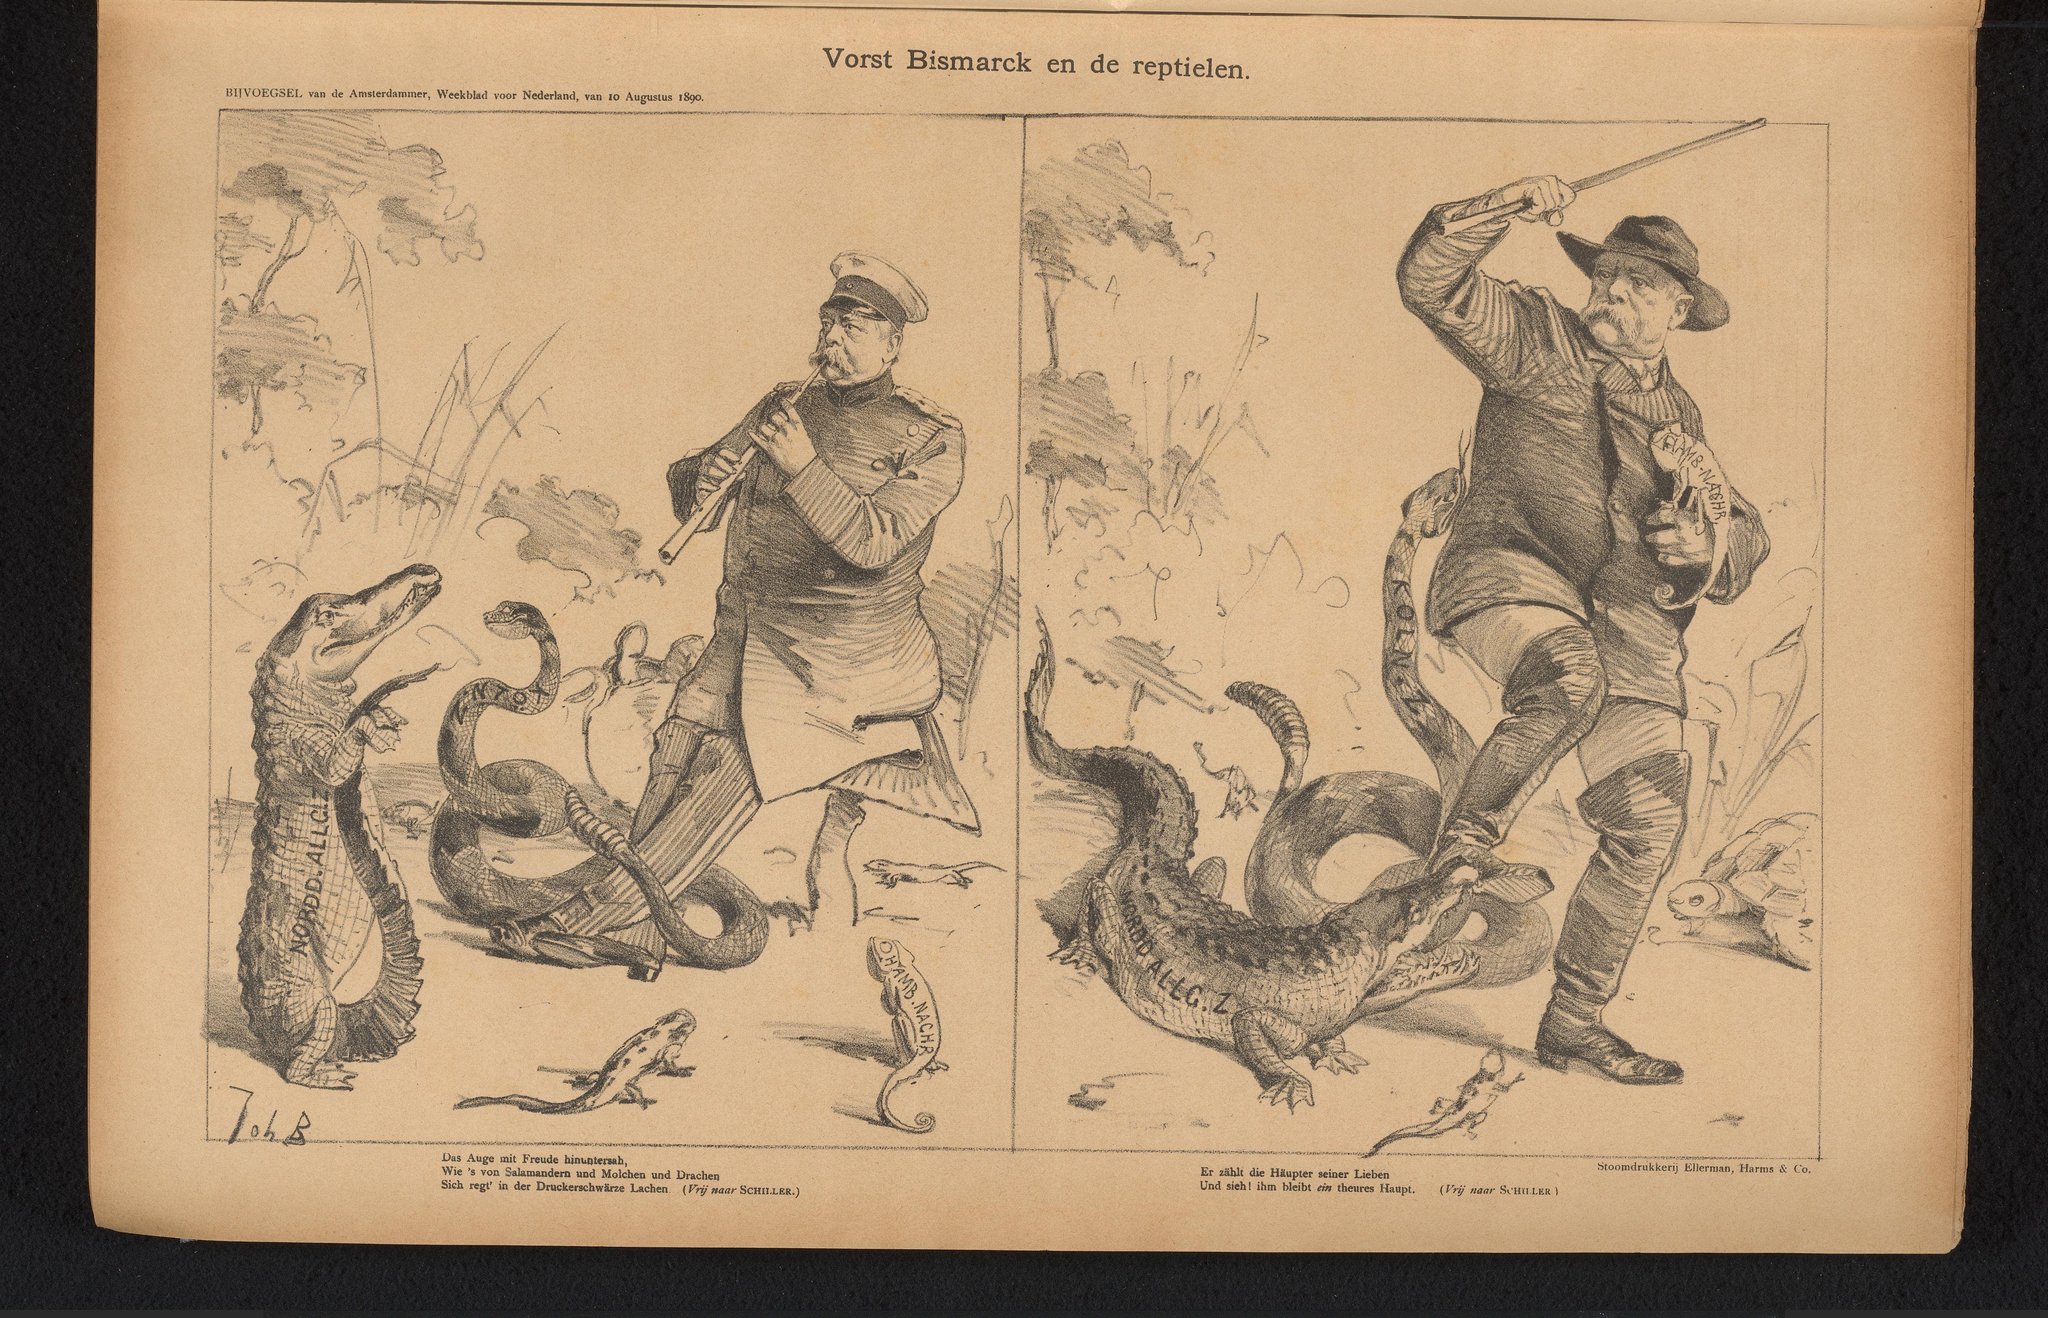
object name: cartoon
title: Vorst Bismarck en de reptielen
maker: johan braakensiek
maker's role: draughtsman, print maker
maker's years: 1858-1940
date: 1890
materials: paper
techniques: lithograph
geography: netherlands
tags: reptiles, flute, aulos, tibia - cc - out of doors, political caricatures and satires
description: Twee voorstellingen van voormalig kanselier Bismarck. Links toen hij nog kanselier was betoverde hij met zijn fluitspel de reptielen, de problemen van Duitsland. Rechts nu hij geen kanselier meer is komen alle problemen terug en vallen hem aan.